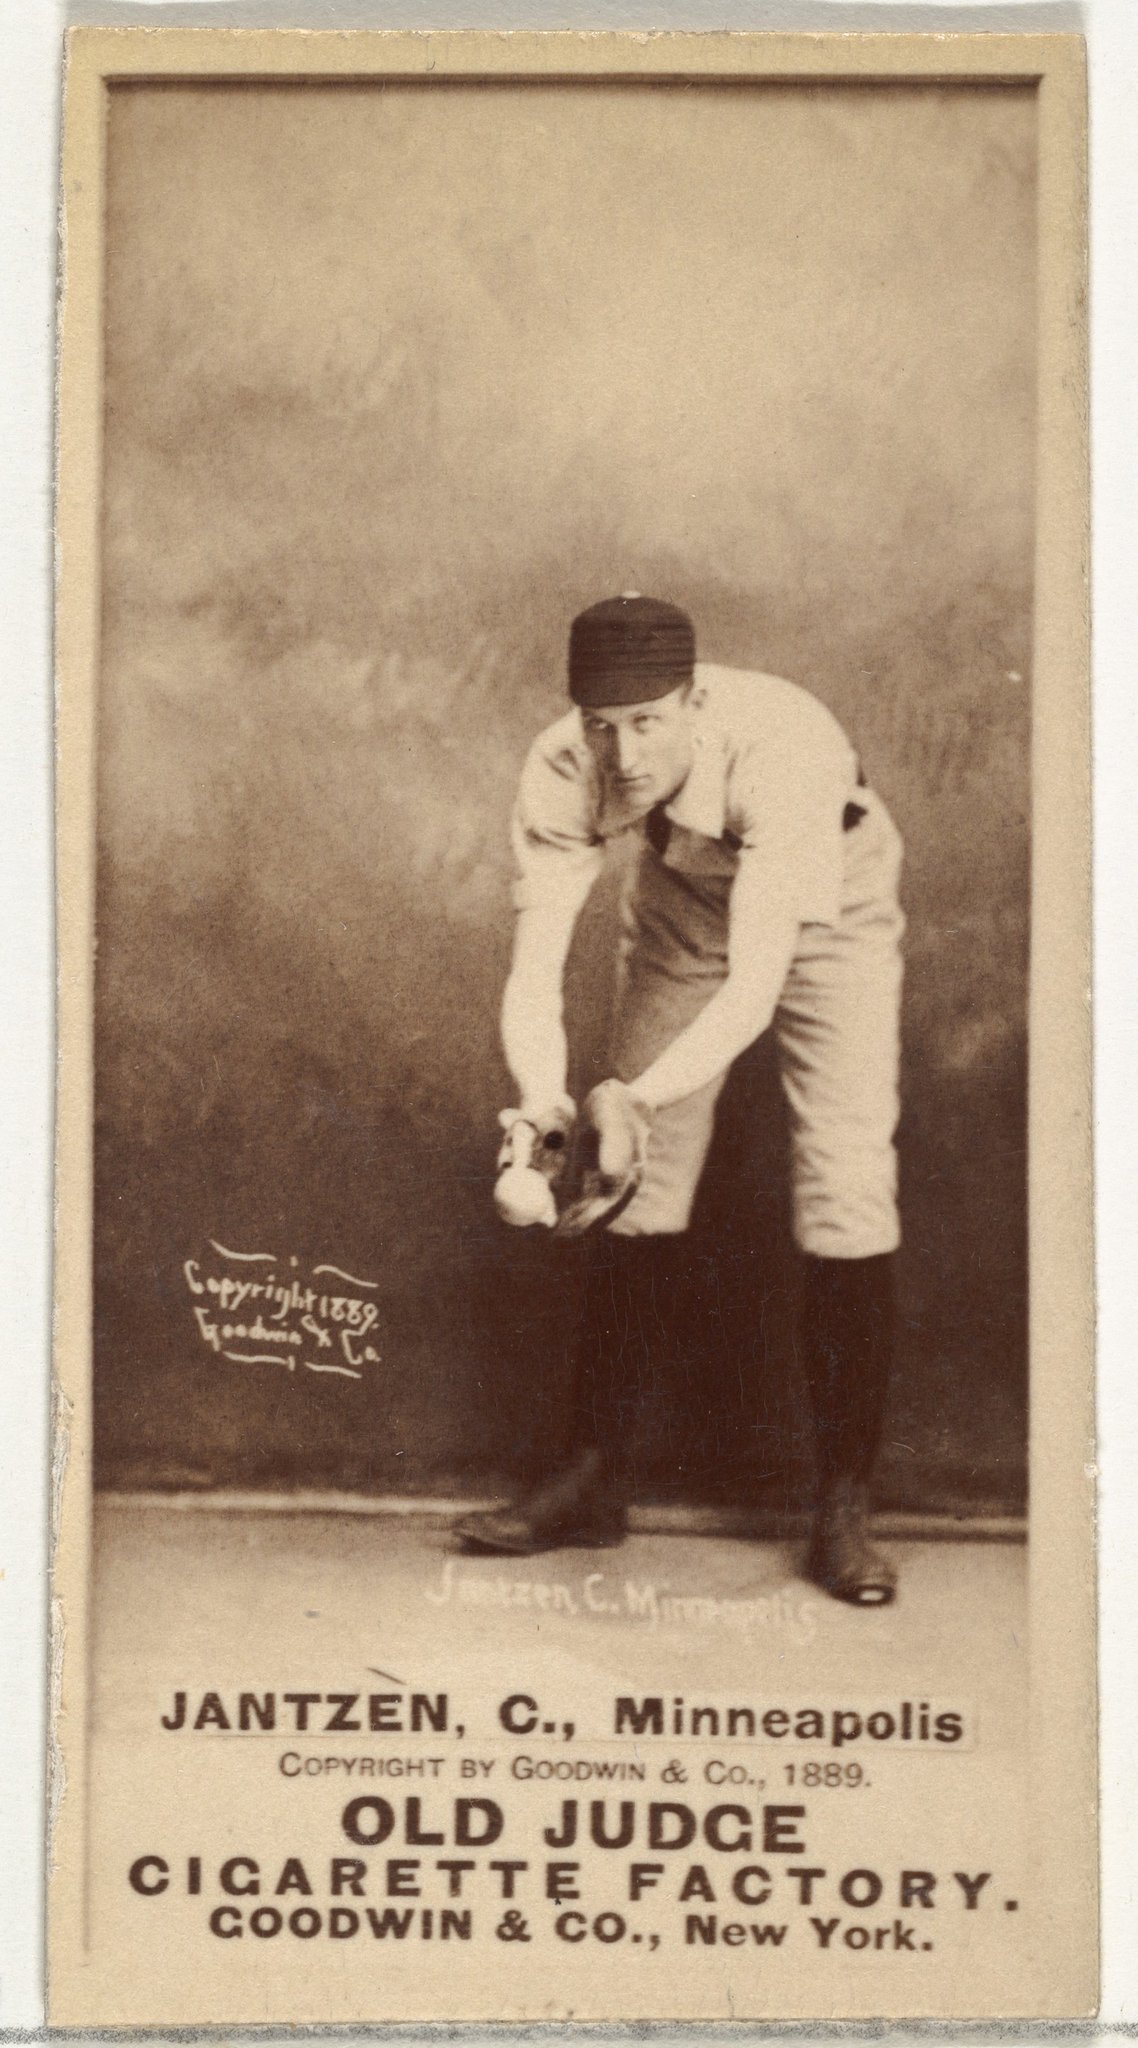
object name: baseball card, photograph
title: Duke Jantzen, Catcher, Minneapolis, from the Old Judge series (N172) for Old Judge Cigarettes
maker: goodwin & company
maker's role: publisher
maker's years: 1850-1950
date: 1889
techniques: albumen silver print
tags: men,portraits,baseball,athletes